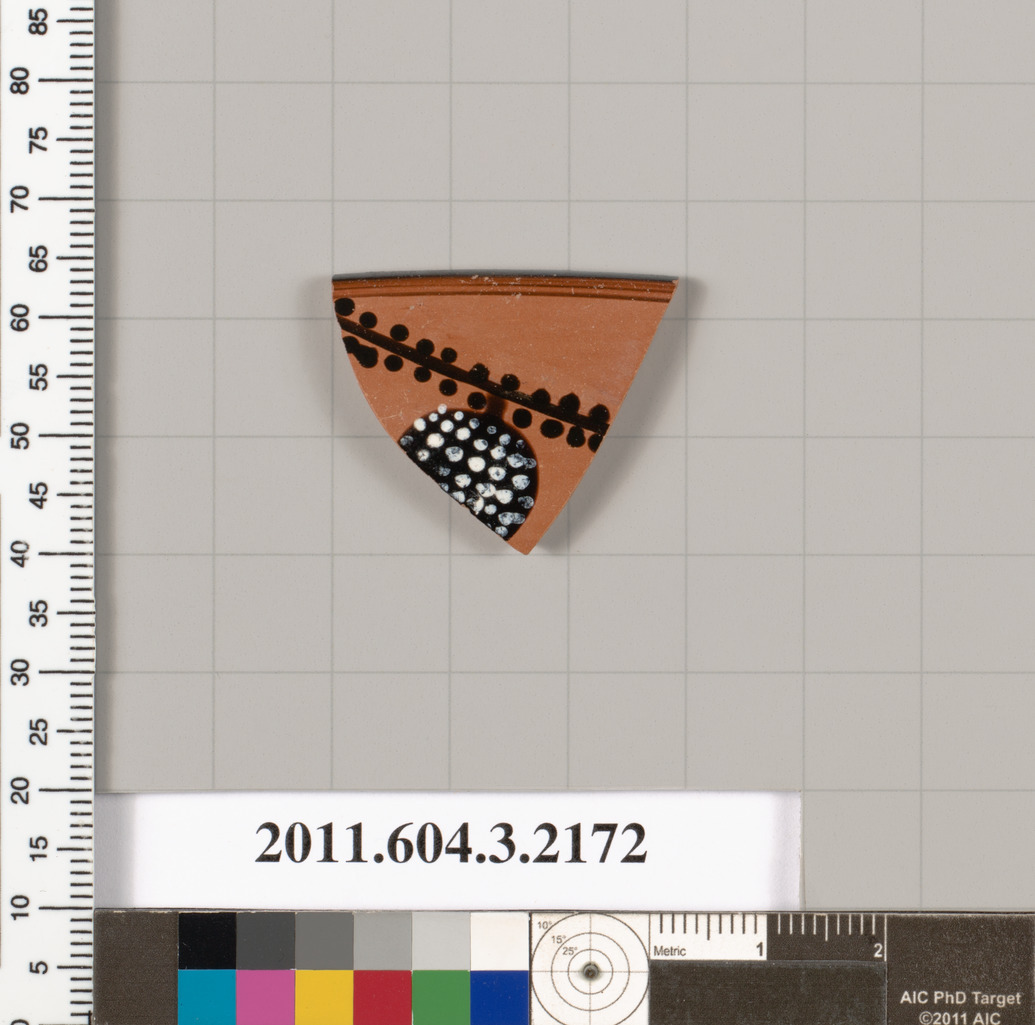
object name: kylix fragment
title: Terracotta rim fragment of a kylix (drinking cup)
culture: greek, attic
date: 550-501 BCE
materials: terracotta